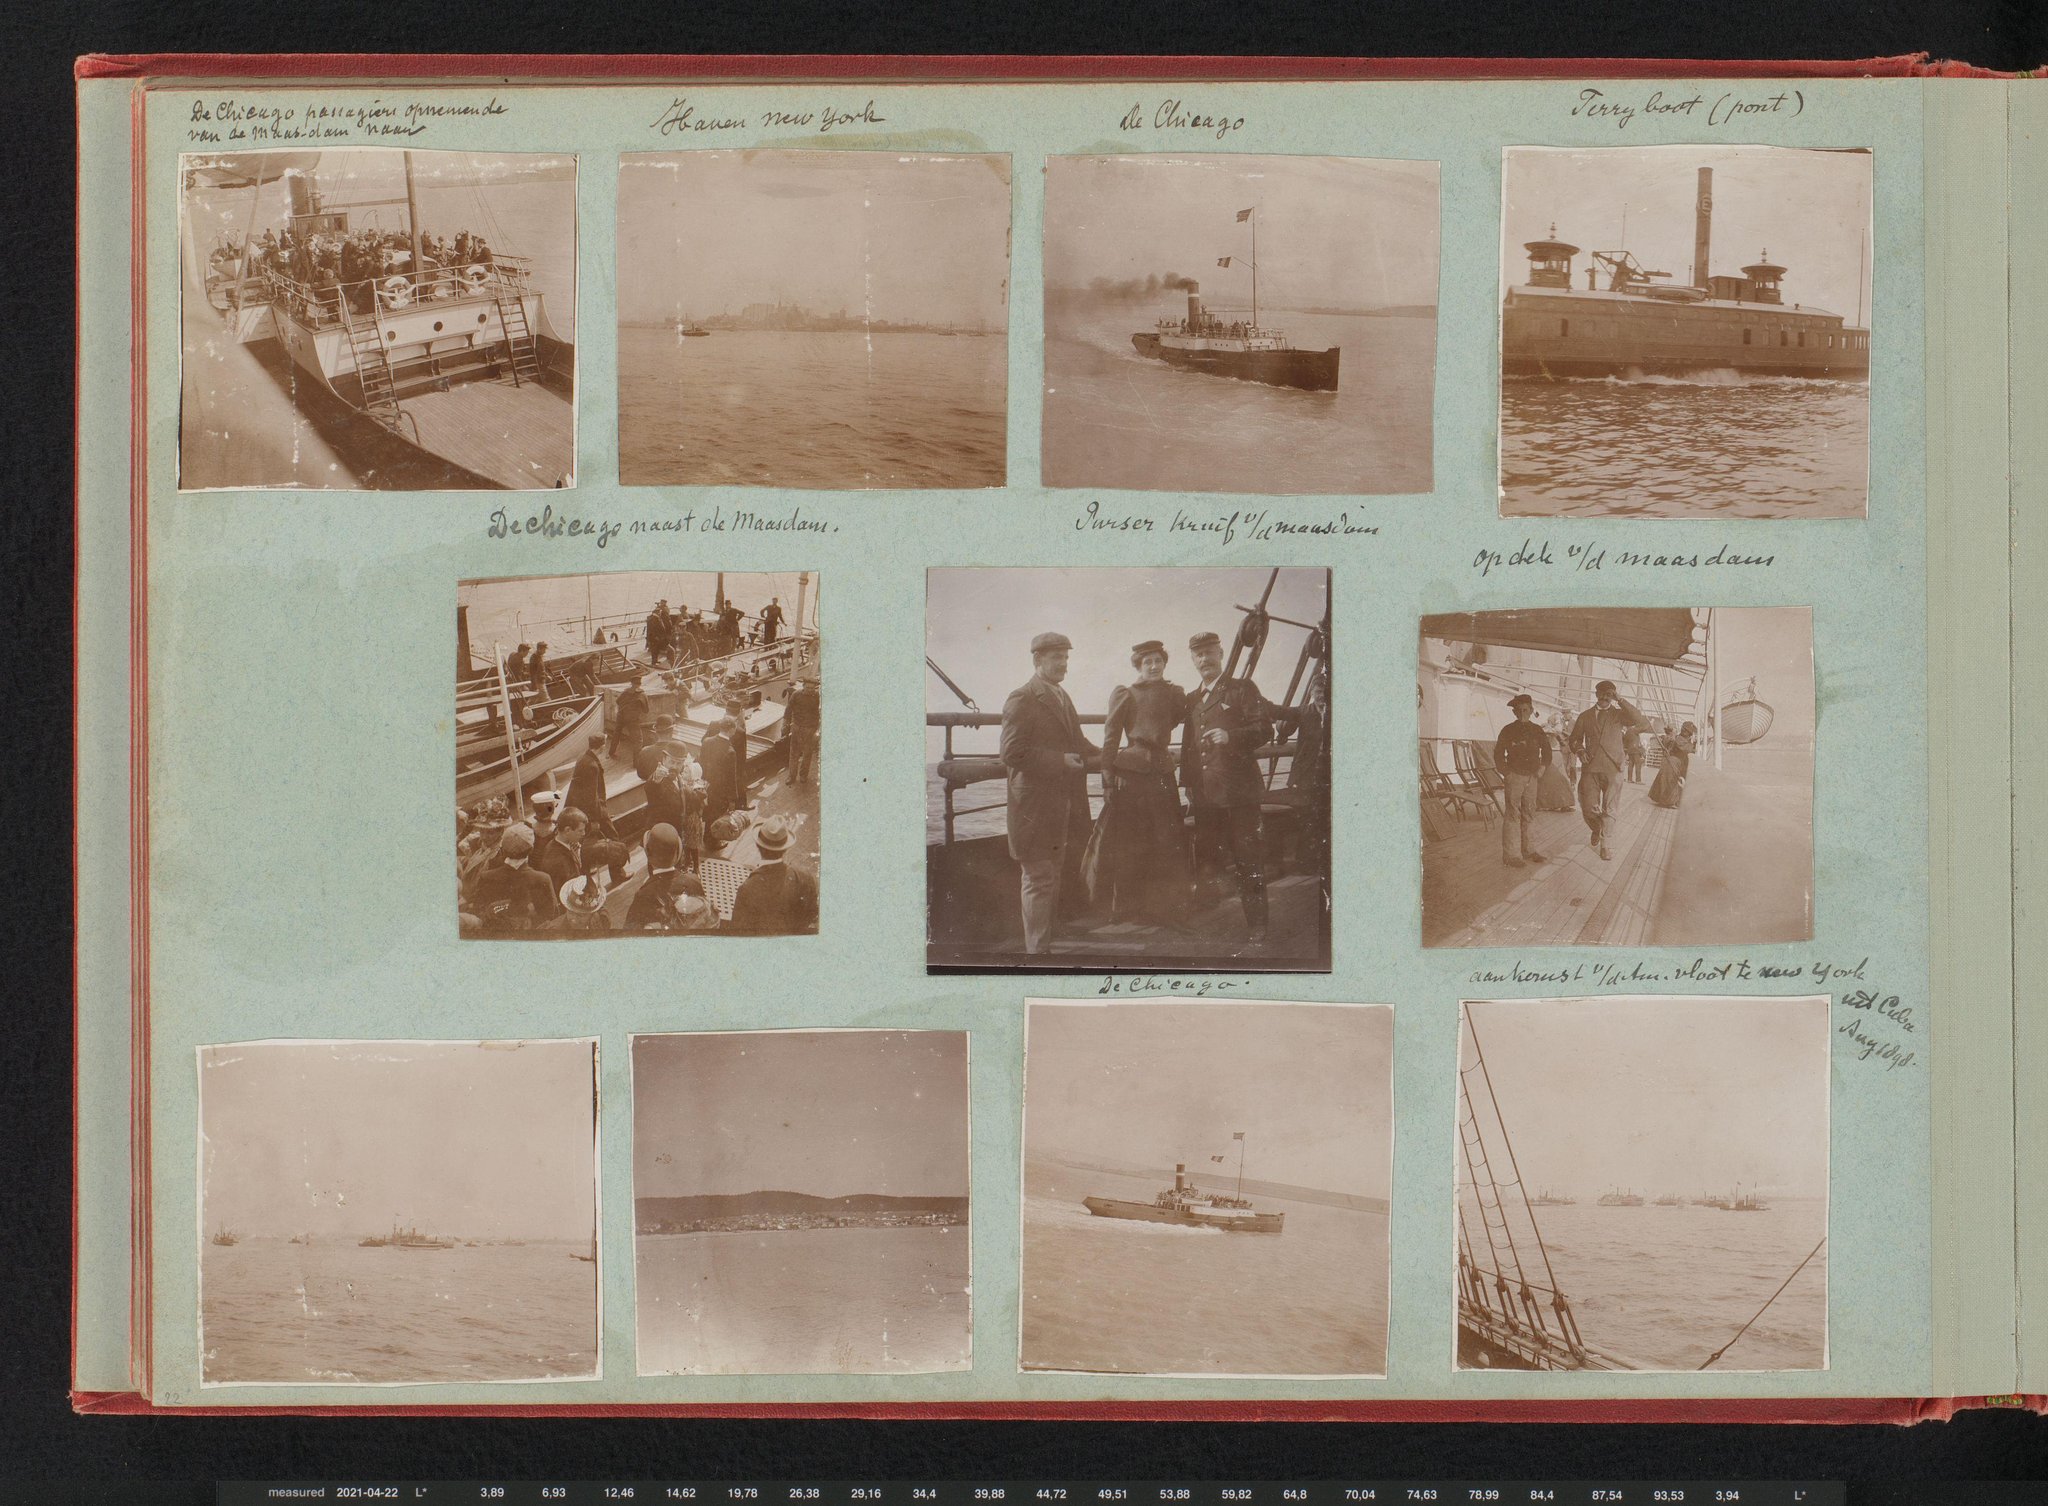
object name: album leaf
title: Reizigers aan boord van de SS Maasdam en de SS Chicago naar New York, onderdeel van de Holland-Amerika Lijn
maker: Anonymous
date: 1898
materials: paper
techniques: collodion silver print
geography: united states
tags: ocean, 'en route', traveller under way, steamship, motorship, new york (city)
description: Deze foto's zijn onderdeel van een album.